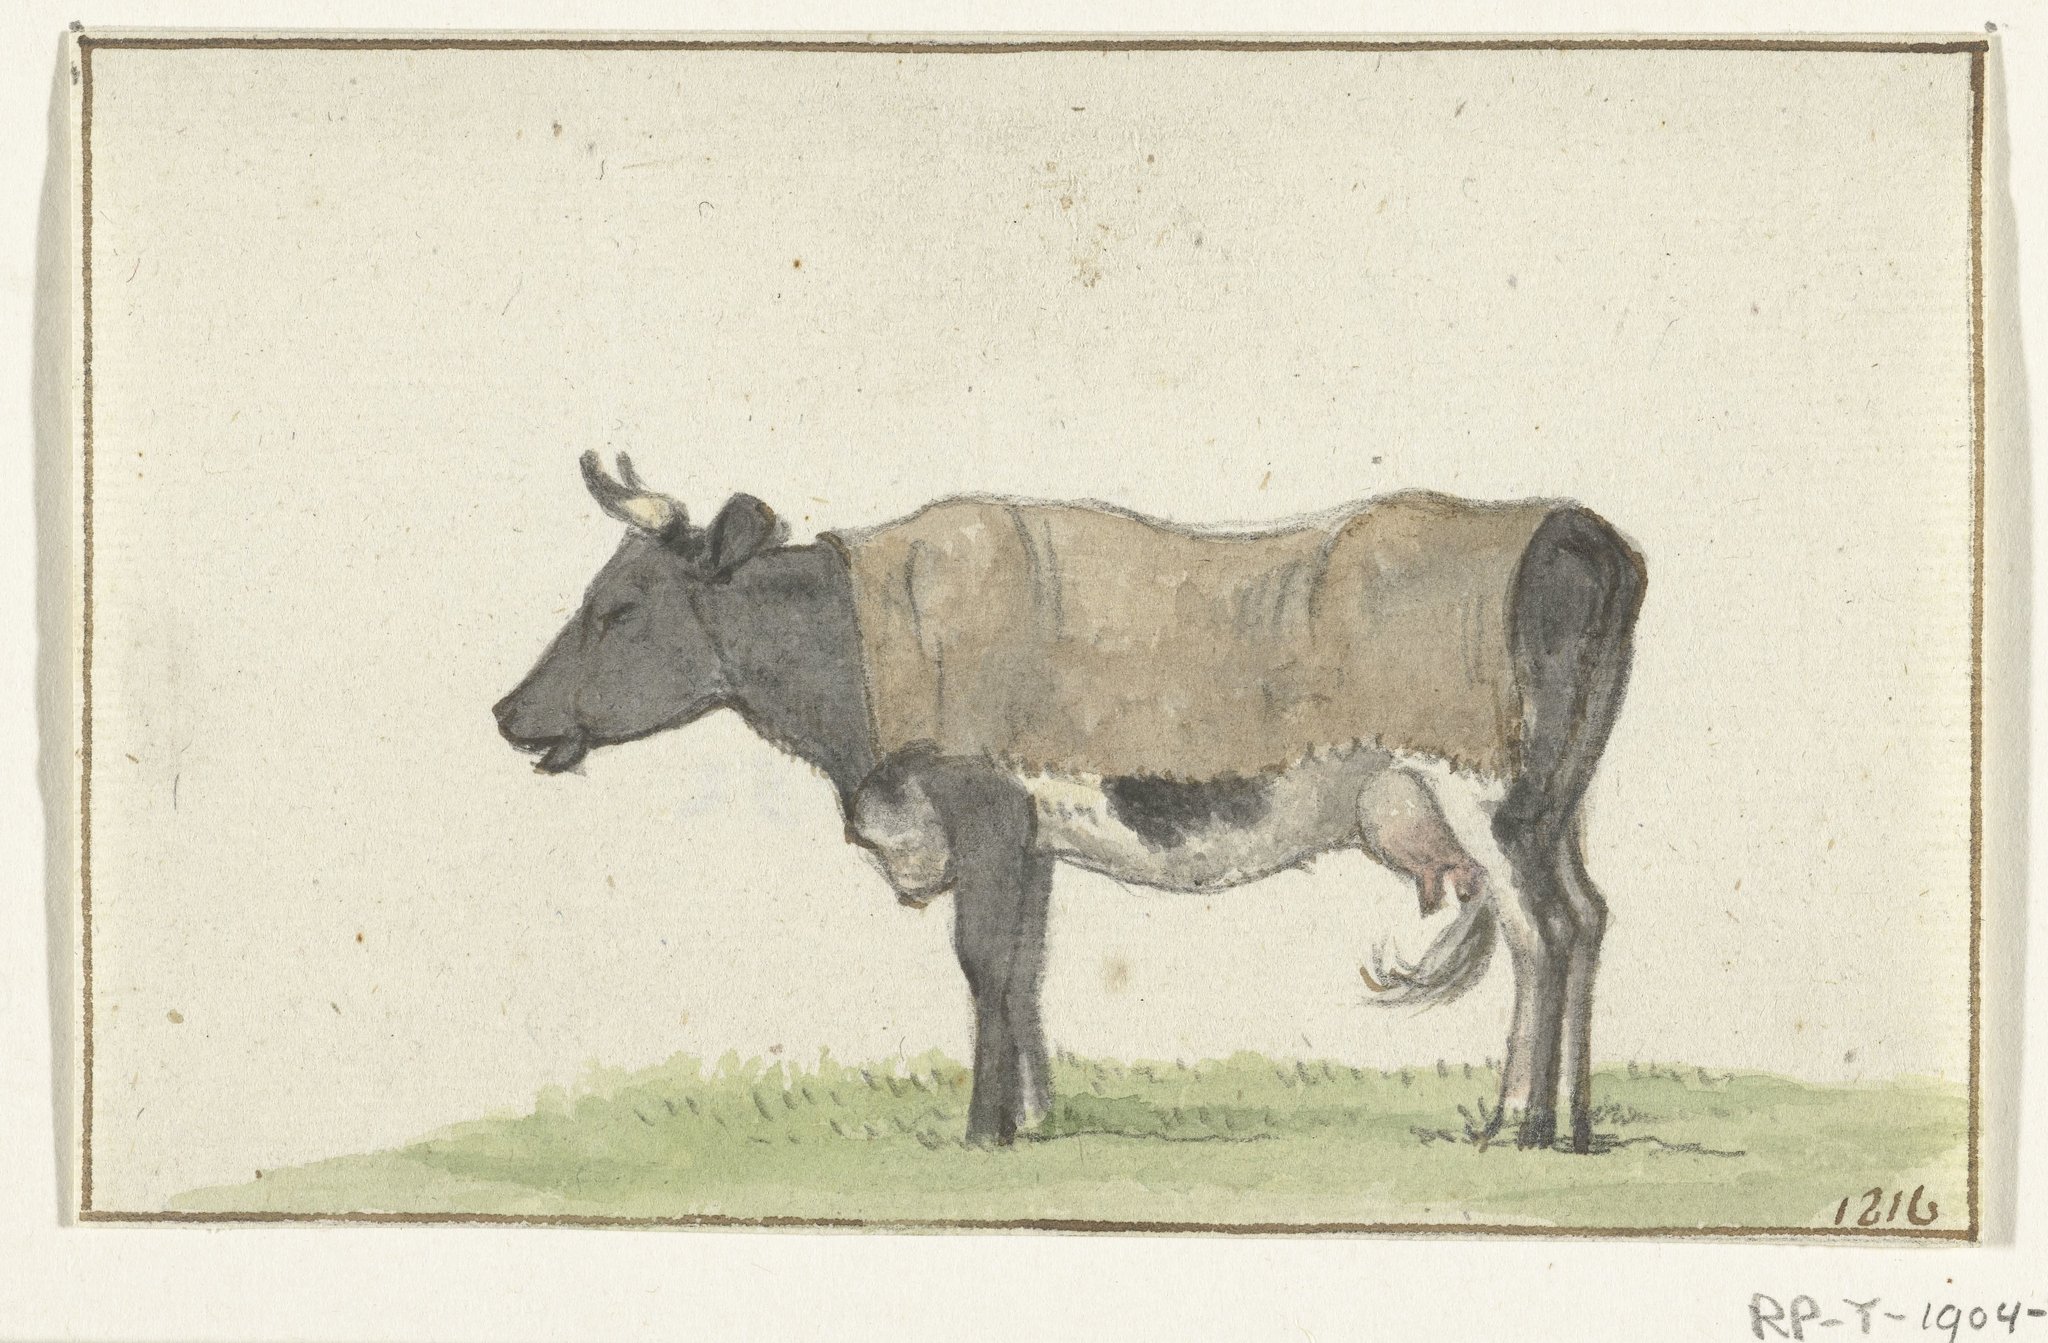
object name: drawing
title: Staande koe met deken, naar links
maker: jean bernard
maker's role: draughtsman, print maker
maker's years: 1765-1833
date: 1816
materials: paper, pencil, watercolor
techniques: brush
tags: cow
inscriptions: date: ‘1816’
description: Staande koe, met deken over de rug, naar links.